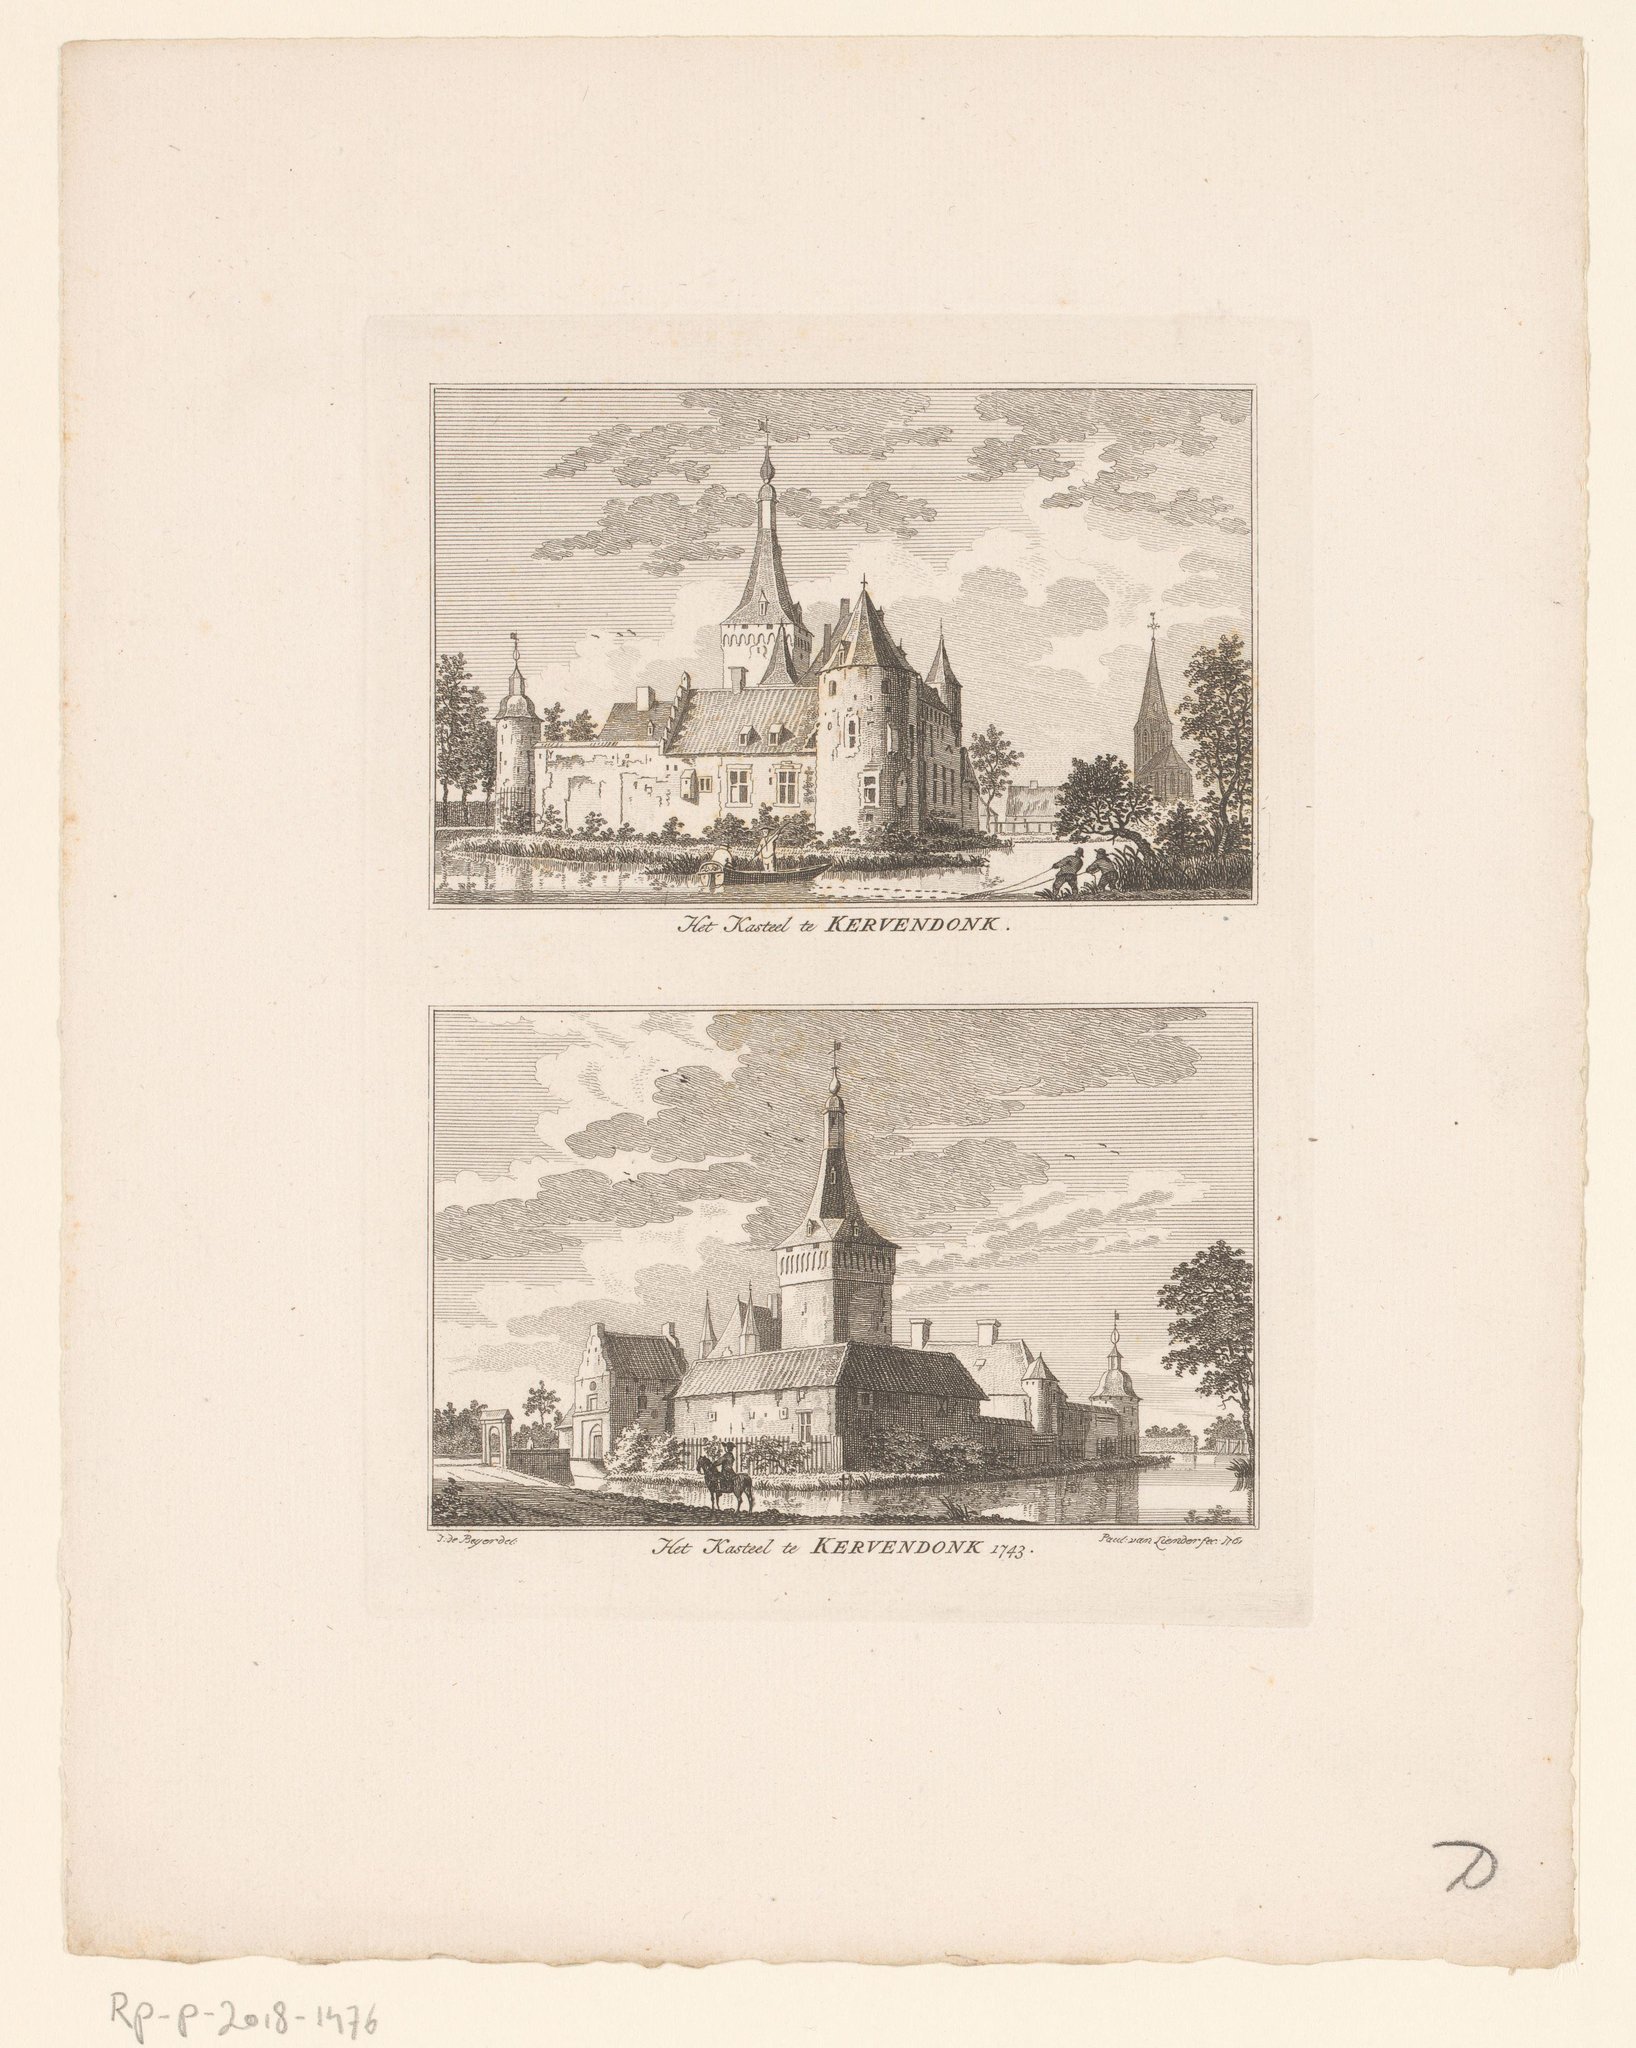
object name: print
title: Burcht te Kervenheim, 1743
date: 1761-1792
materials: paper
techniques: engraving, etching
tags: landscape with tower or castle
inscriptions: collector's mark: Lugt 2228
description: Prent ook gebruikt in: Beijer, Jan de. Het verheerlykt Kleefschland of Kabinet van Kleefsche oudheden en gezigten. Amsterdam: Jan de Groot et al., 1792.